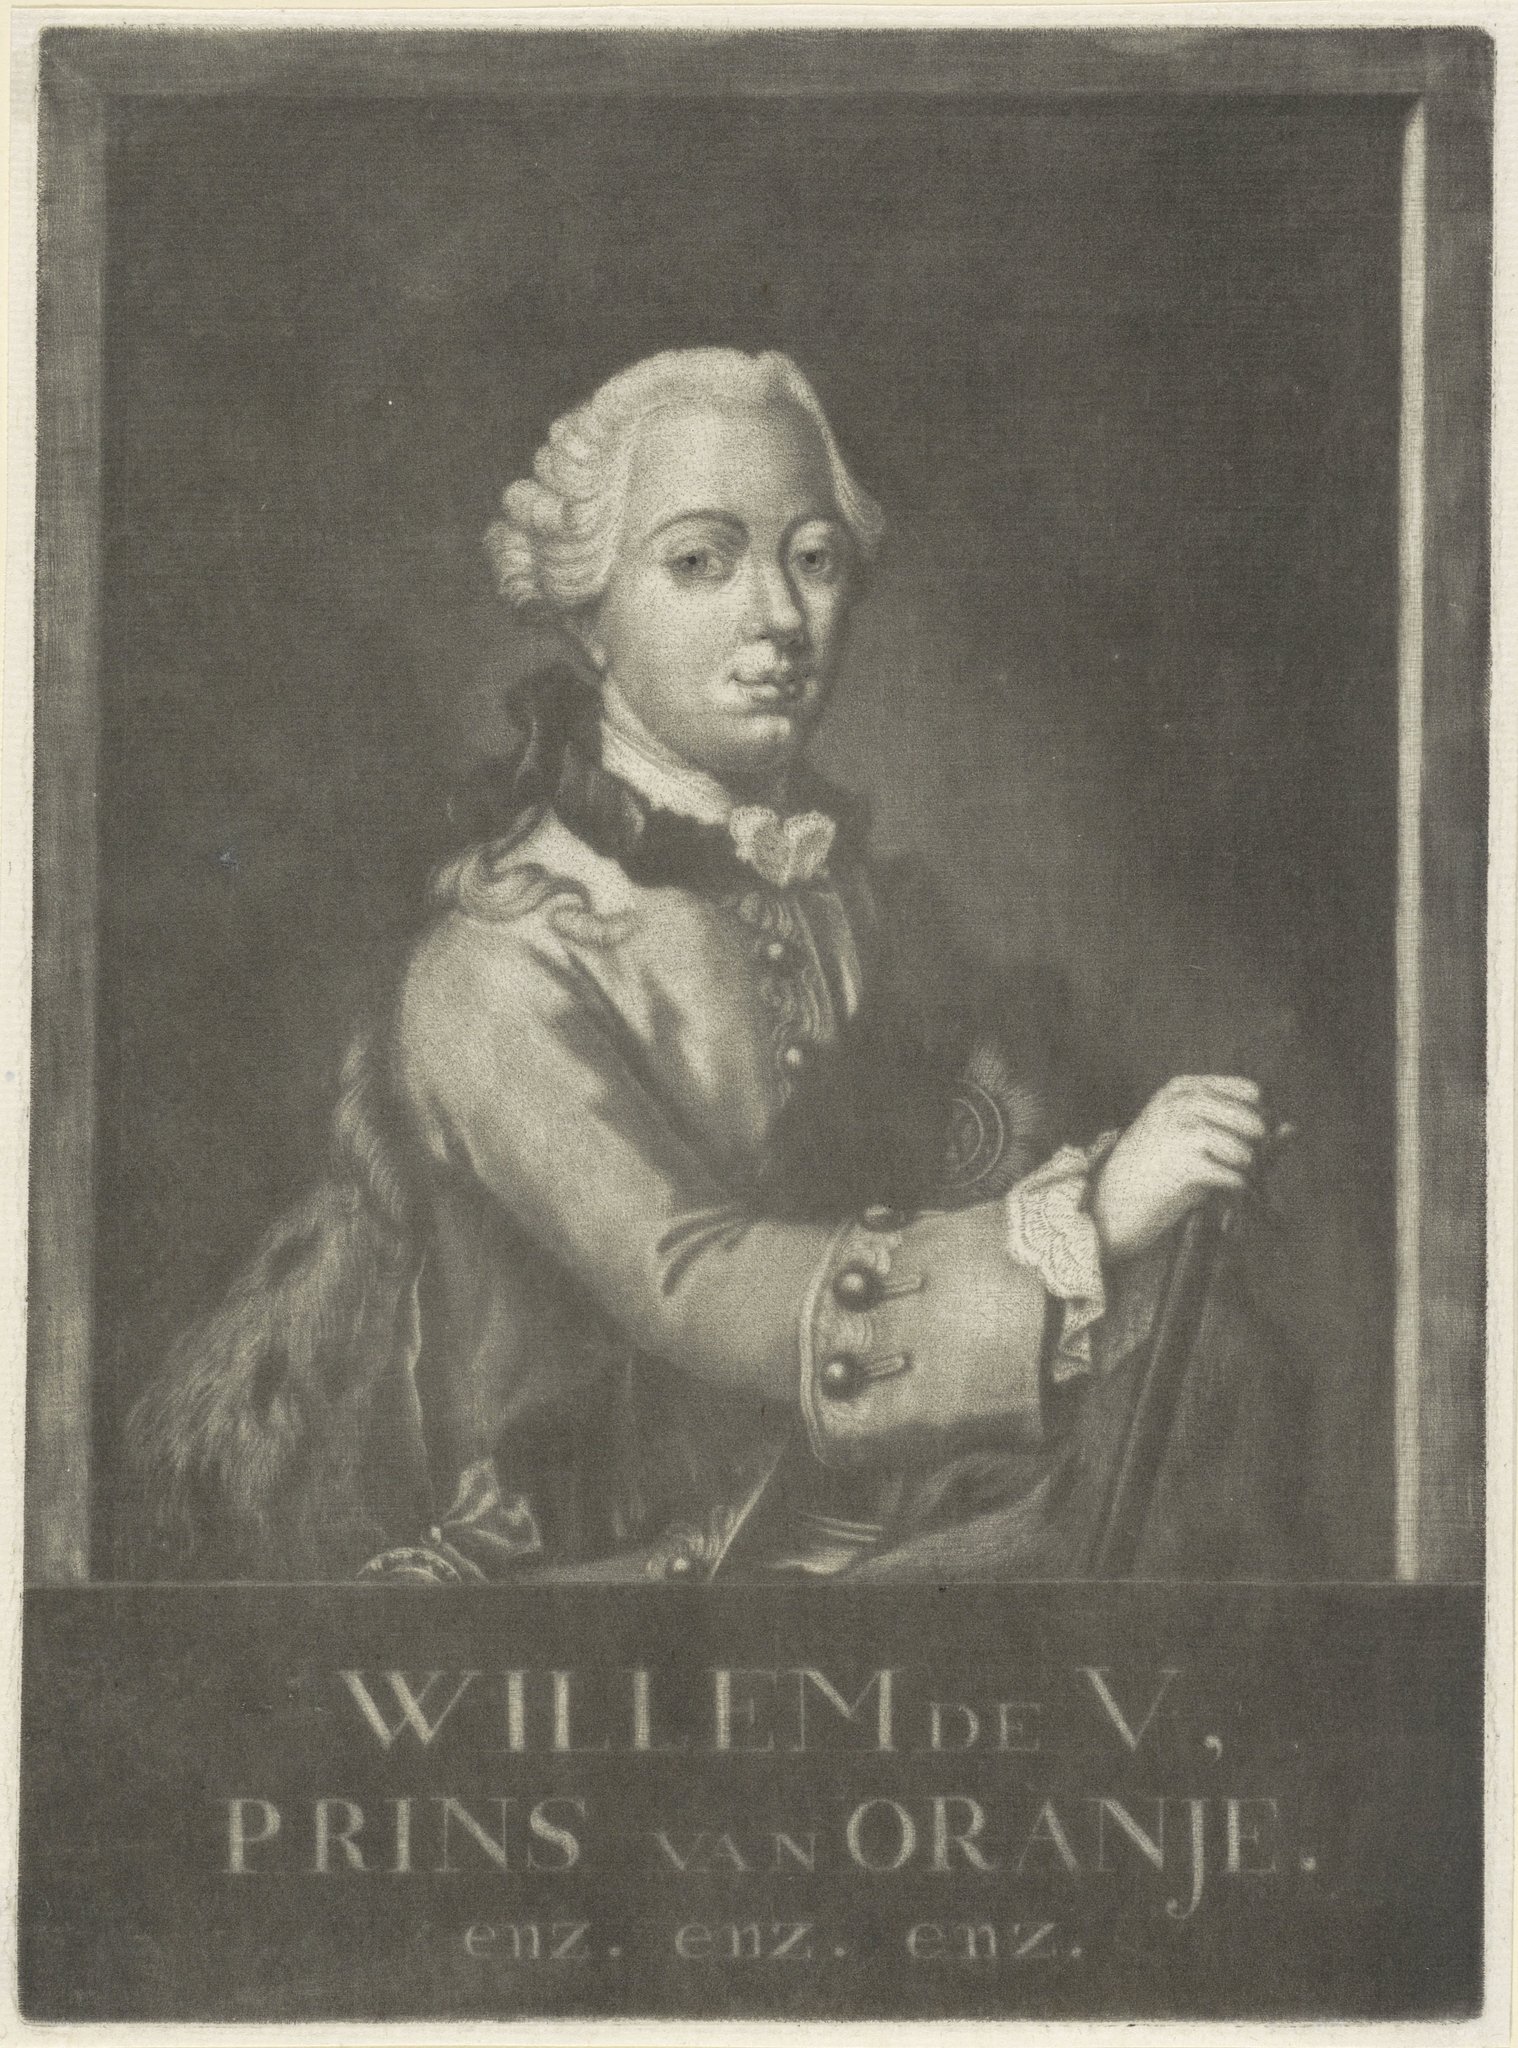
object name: book illustration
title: Portret van Willem V, prins van Oranje-Nassau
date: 1770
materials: paper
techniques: mezzotint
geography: leeuwarden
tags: the hague, william v (prince of orange)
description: De hier vermelde titel verwijst naar de hoogst verkregen titel van de geportretteerde, niet per se naar de titel die de geportretteerde op deze voorstelling draagt. Prent uit: Bosch, Johannes van den. De heeren stadhouderen van Vriesland, zedert den jare acht-hondert, volgens hoogst derzelver successie kortelyk beschreven. Leeuwarden: Abraham Ferwerda en Gerrit Tresling, 1770.